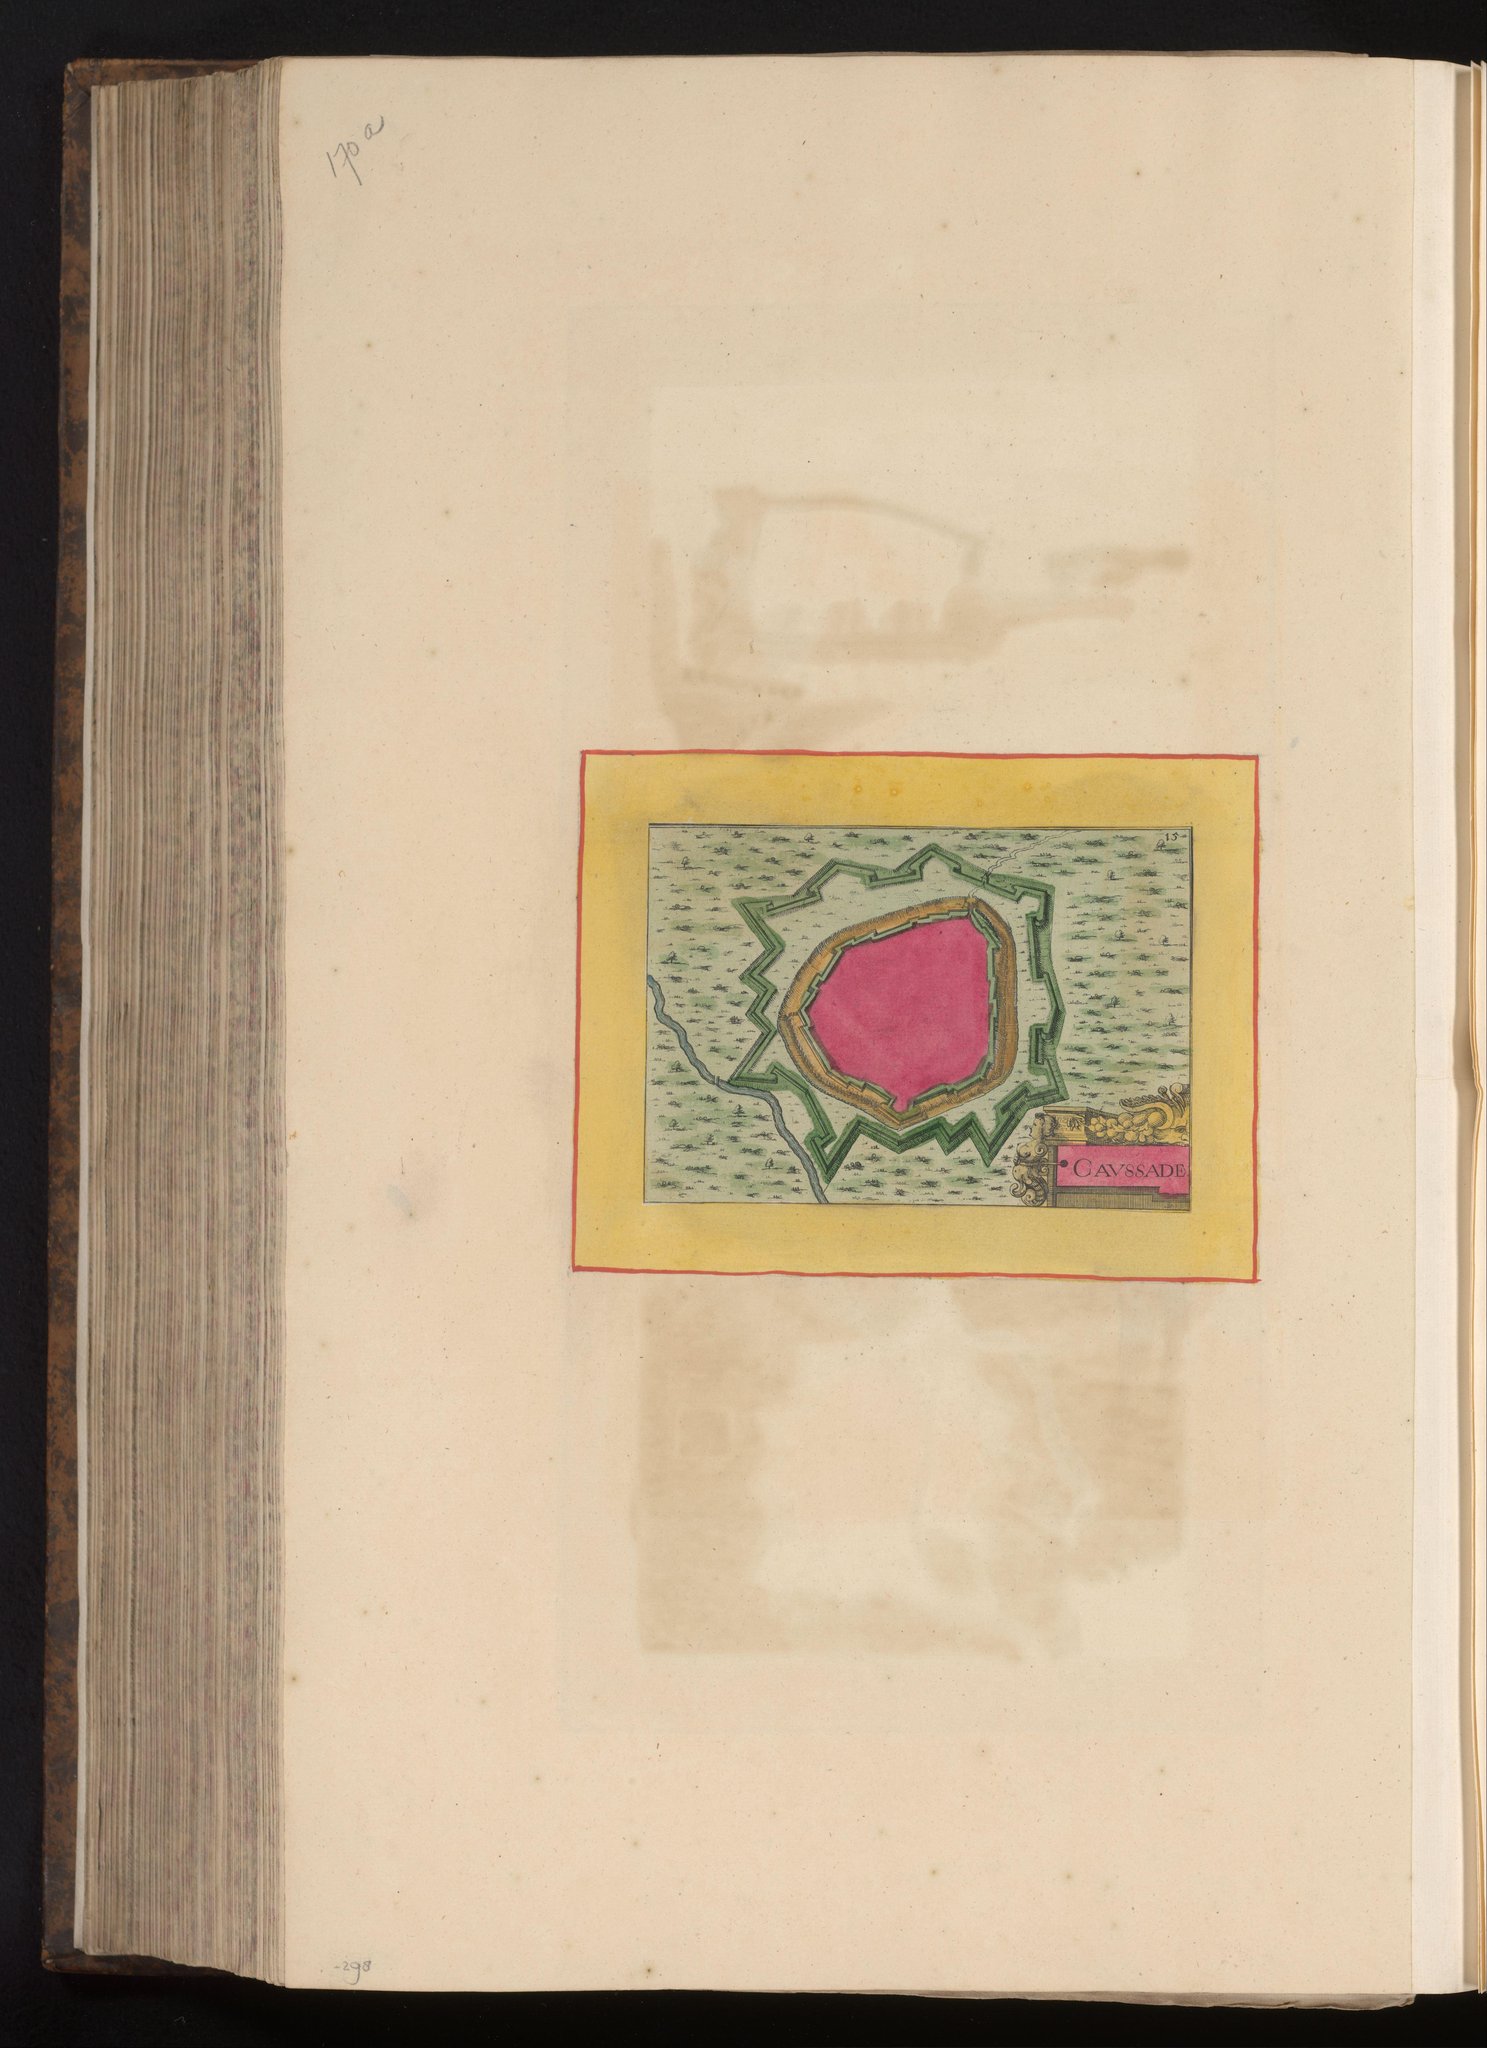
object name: area plan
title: Vestingplattegrond van Caussade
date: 1638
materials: paper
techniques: engraving, etching, hand coloring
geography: paris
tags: maps of cities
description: Prent uit: Tassin, Christophe. Les plans et profils de toutes les principales villes et lieux considérables de France (...). Parijs: Michel van Lochom, 1638, prent nummer 15 in het deel 'Languedoc'.